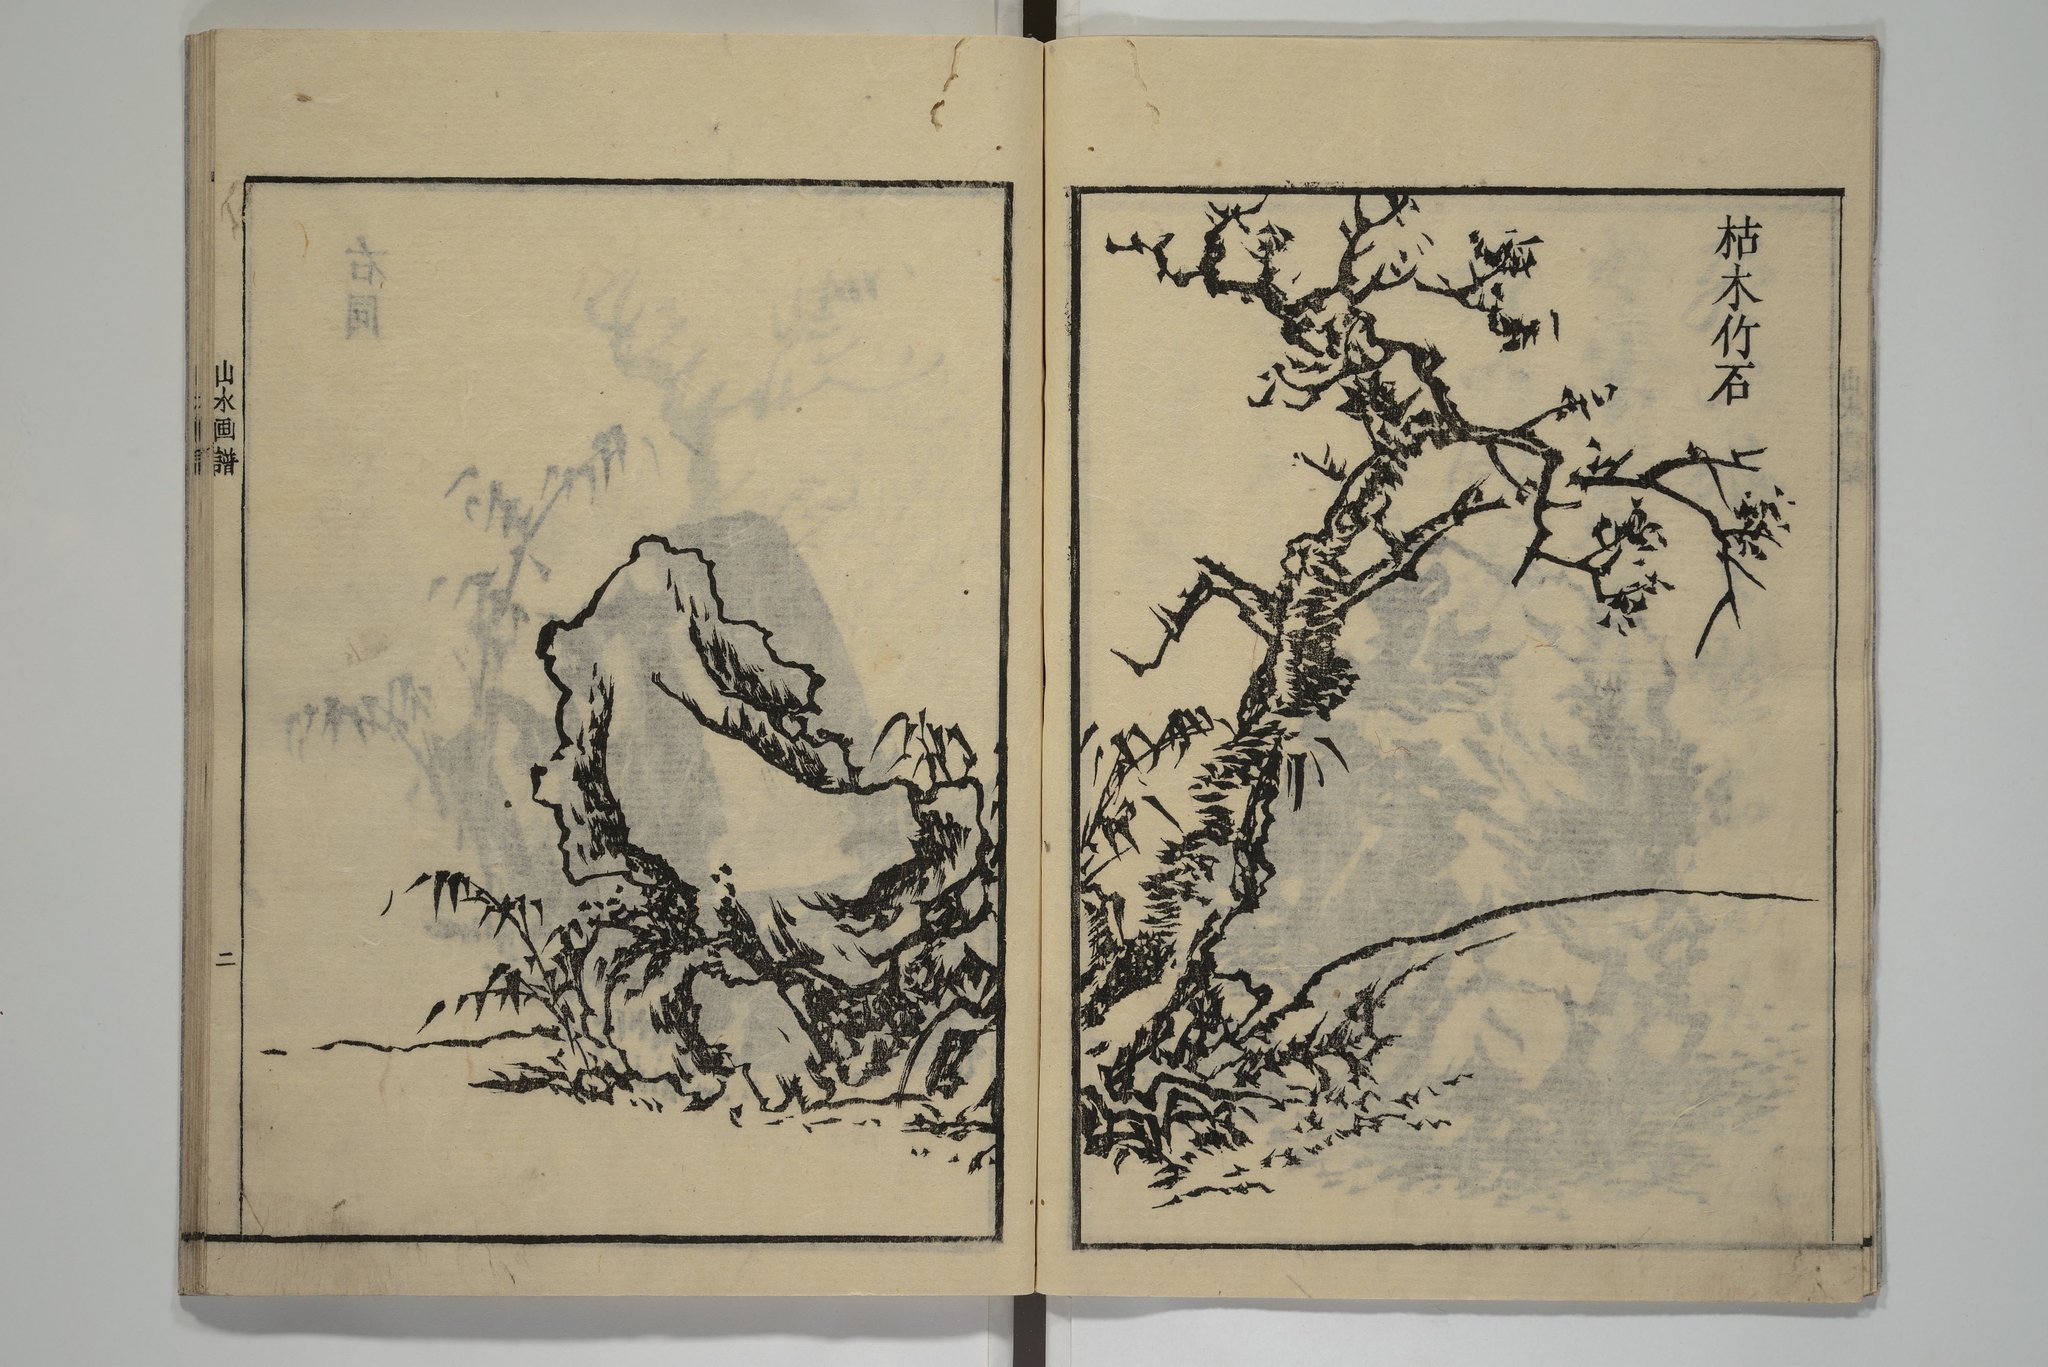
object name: illustrated book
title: Soken Landscape Picture Album (Soken sansui gafu) 素絢山水画譜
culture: japanese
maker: yamaguchi soken 山口素絢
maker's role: artist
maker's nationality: japanese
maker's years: 1759-1818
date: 1818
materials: ink, paper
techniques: hand coloring, woodblock print